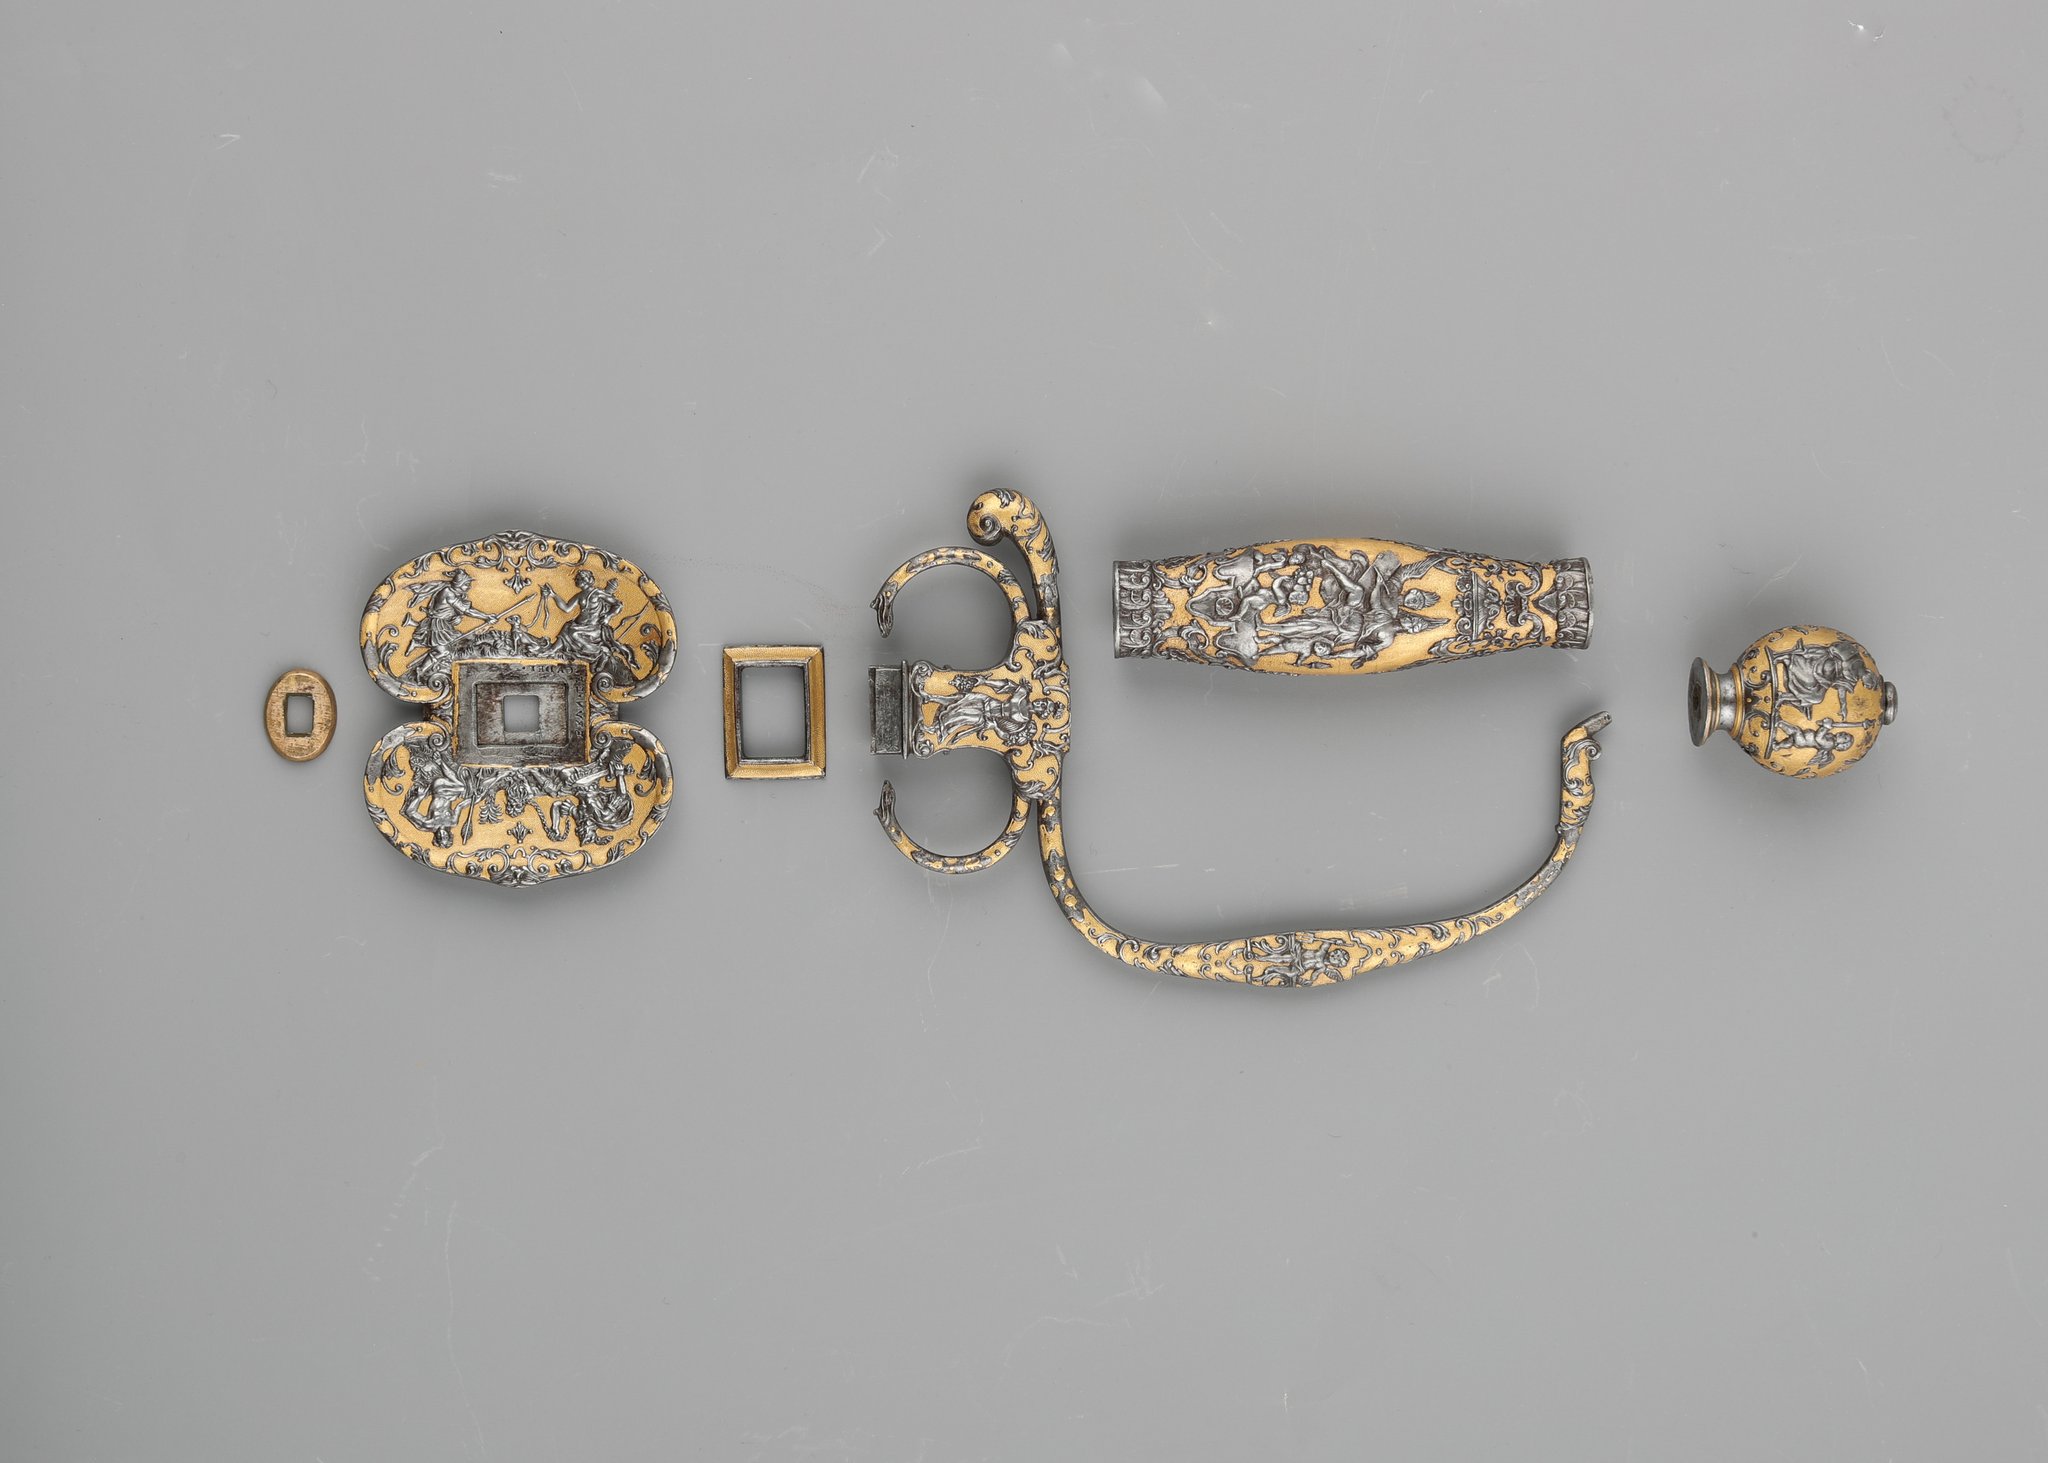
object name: smallsword hilt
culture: french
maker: lebrun the younger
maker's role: hilt maker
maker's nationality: french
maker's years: 1705-1755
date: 1730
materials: gold, steel, wood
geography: france